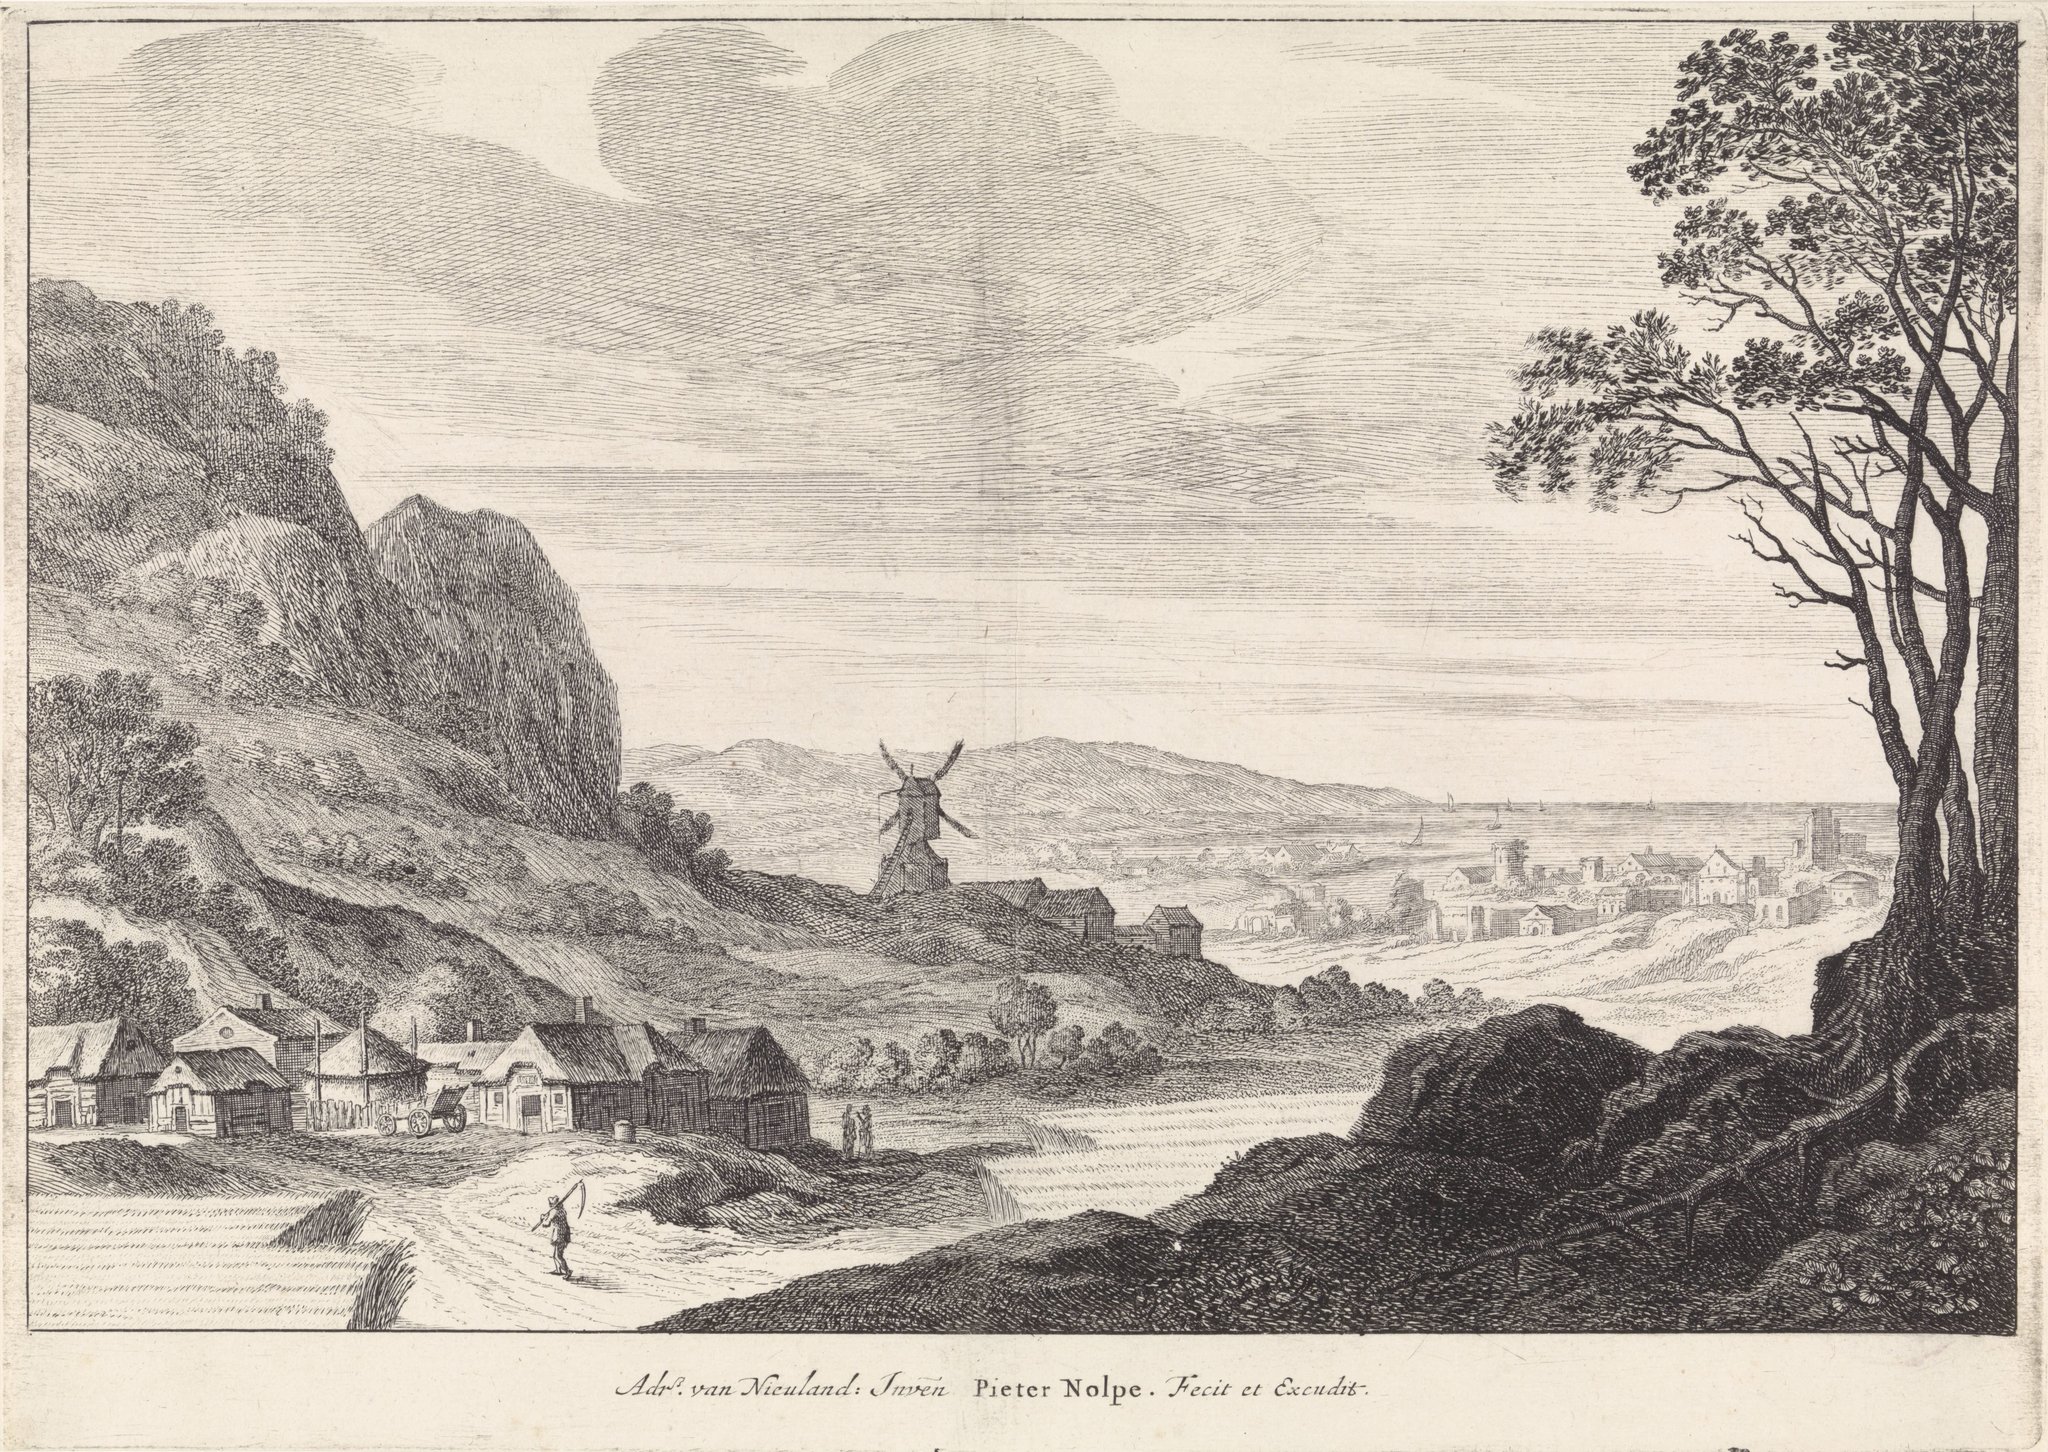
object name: print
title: Landschappen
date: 1623-1653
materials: paper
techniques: engraving, etching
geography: amsterdam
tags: cereal, grain, corn (grass with grains, grown for food, e.g.: wheat, rice, rye, oats, maize, buckwheat, millet), windmill, coast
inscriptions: collector's mark: Lugt 240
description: Heuvelachtig landschap met graanvelden, een boerendorp en een molen. Rechtsachter een dorp aan zee. Prent uit een serie landschappen.